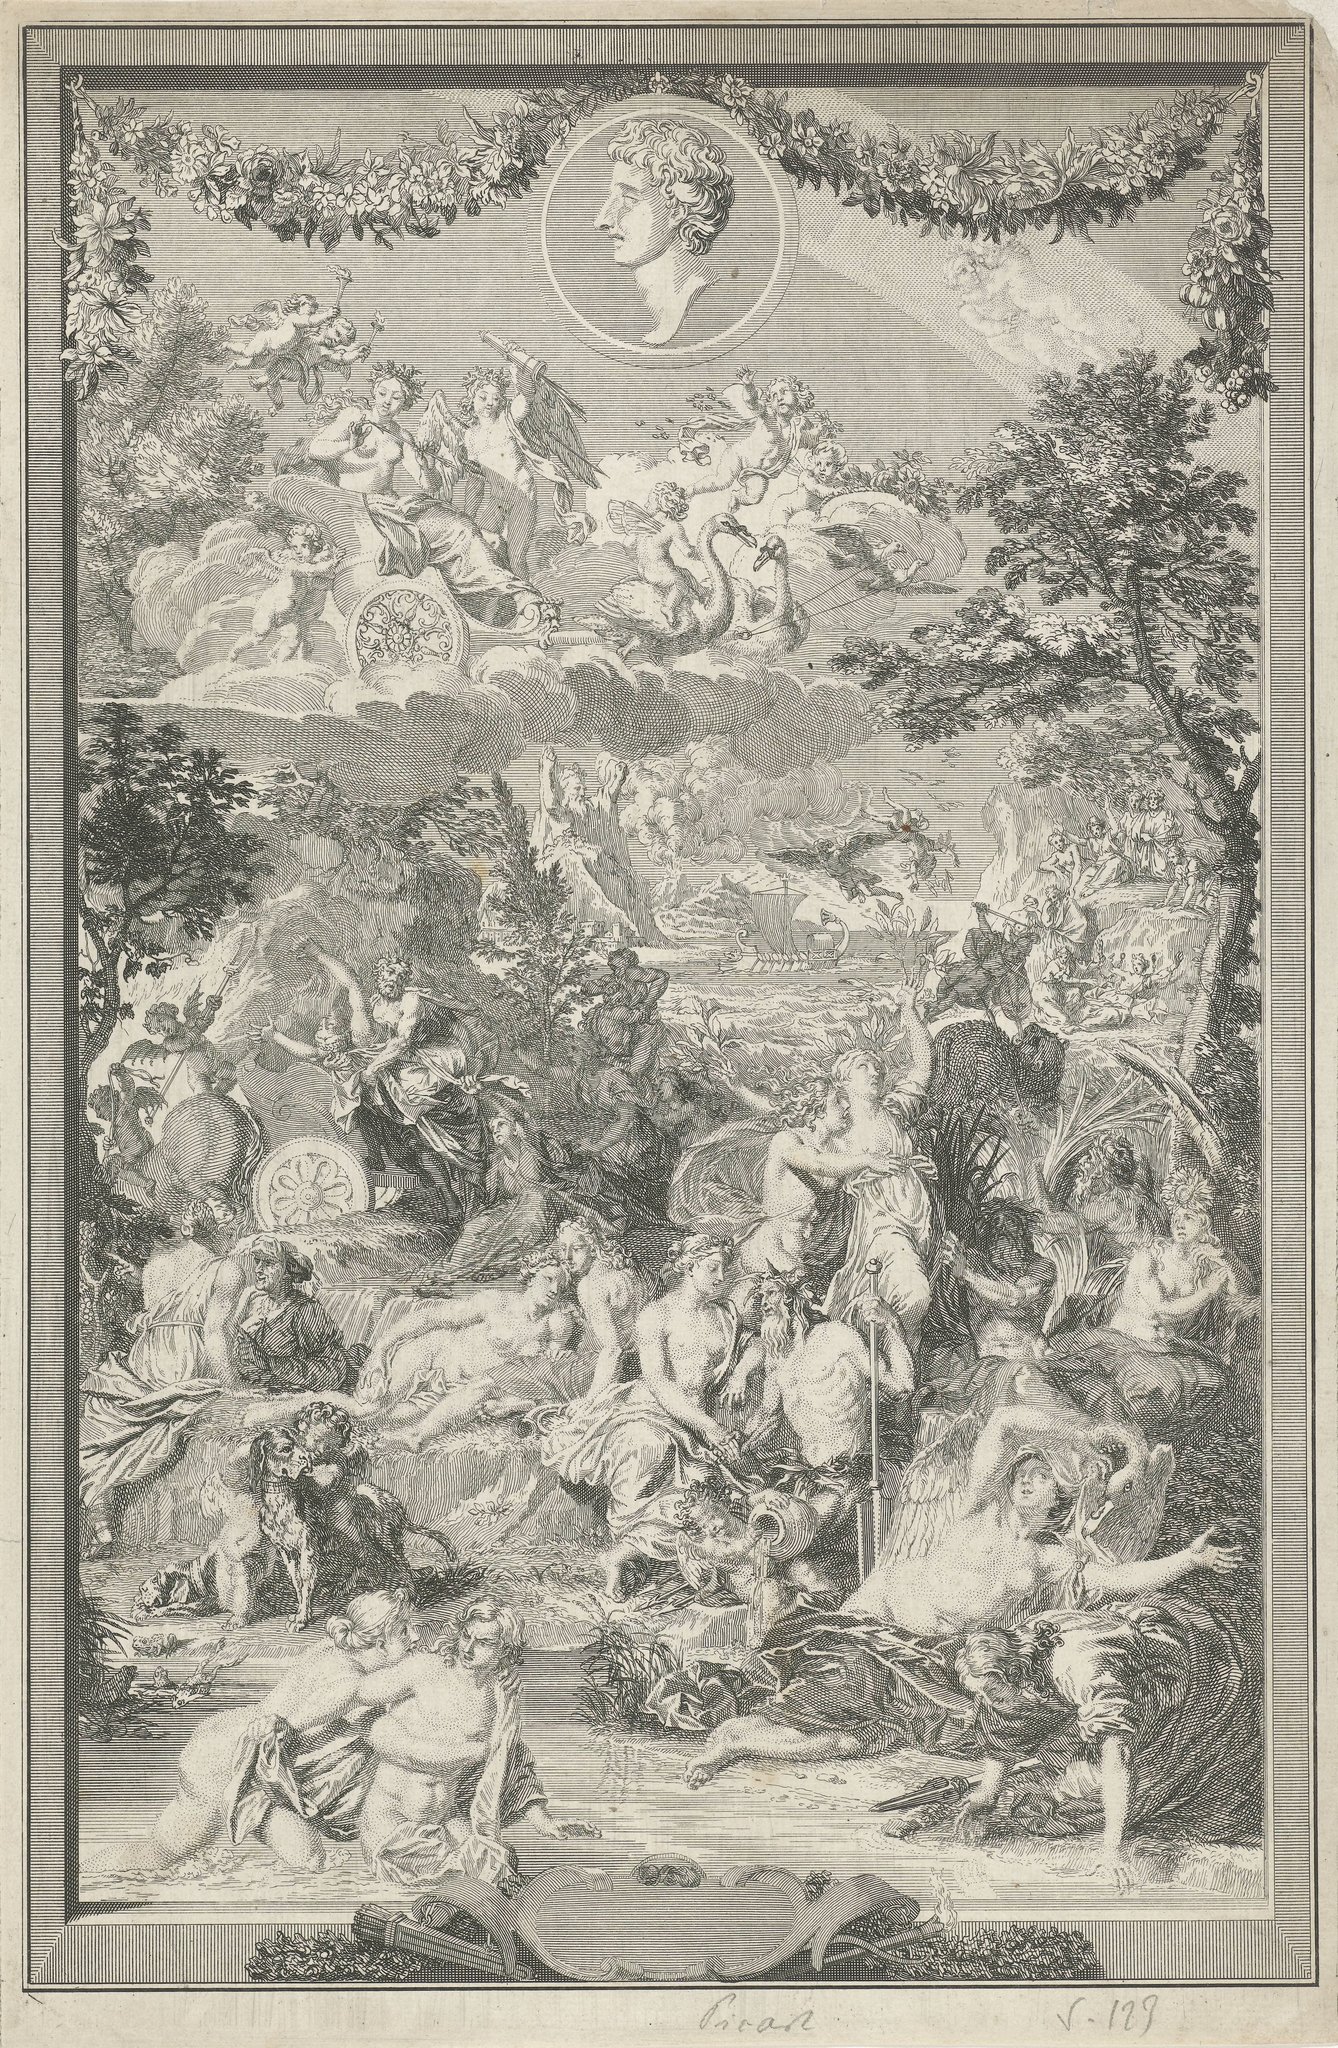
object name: print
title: Allegorische titelpagina met verschillende scènes uit de metamorfosen van Ovidius en diens portret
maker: bernard picart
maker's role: draughtsman, print maker, publisher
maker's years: 1673-1733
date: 1731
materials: paper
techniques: engraving, etching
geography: amsterdam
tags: publius ovidius naso, story of hermaphroditus and salmacis, title-page, metamorphoses ~ classical mythology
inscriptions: collector's mark: Lugt 2228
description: Allegorische voorstelling met verschillende scènes en metamorfosen uit het boek van Ovidius. Onder andere op de voorgrond Salmacis en Hermaphroditus, Narcissus die verliefd wordt op zijn eigen spiegelbeeld en Leda verleid door Jupiter in de gedaante van een zwaan. In het midden Vertumnus als oude vrouw en Pomona, Apollo en Daphne, Pan en Syrinx. Op de achtergrond Pluto en Proserpina, Perseus en het monster, de val van Icarus. In de lucht op een wolk Venus in haar wagen, voortgetrokken door een zwaan. Bovenaan in een medaillon onder een guirlande het portret van de schrijver Publius Ovidius Naso. Onder de voorstelling een leeg cartouche.